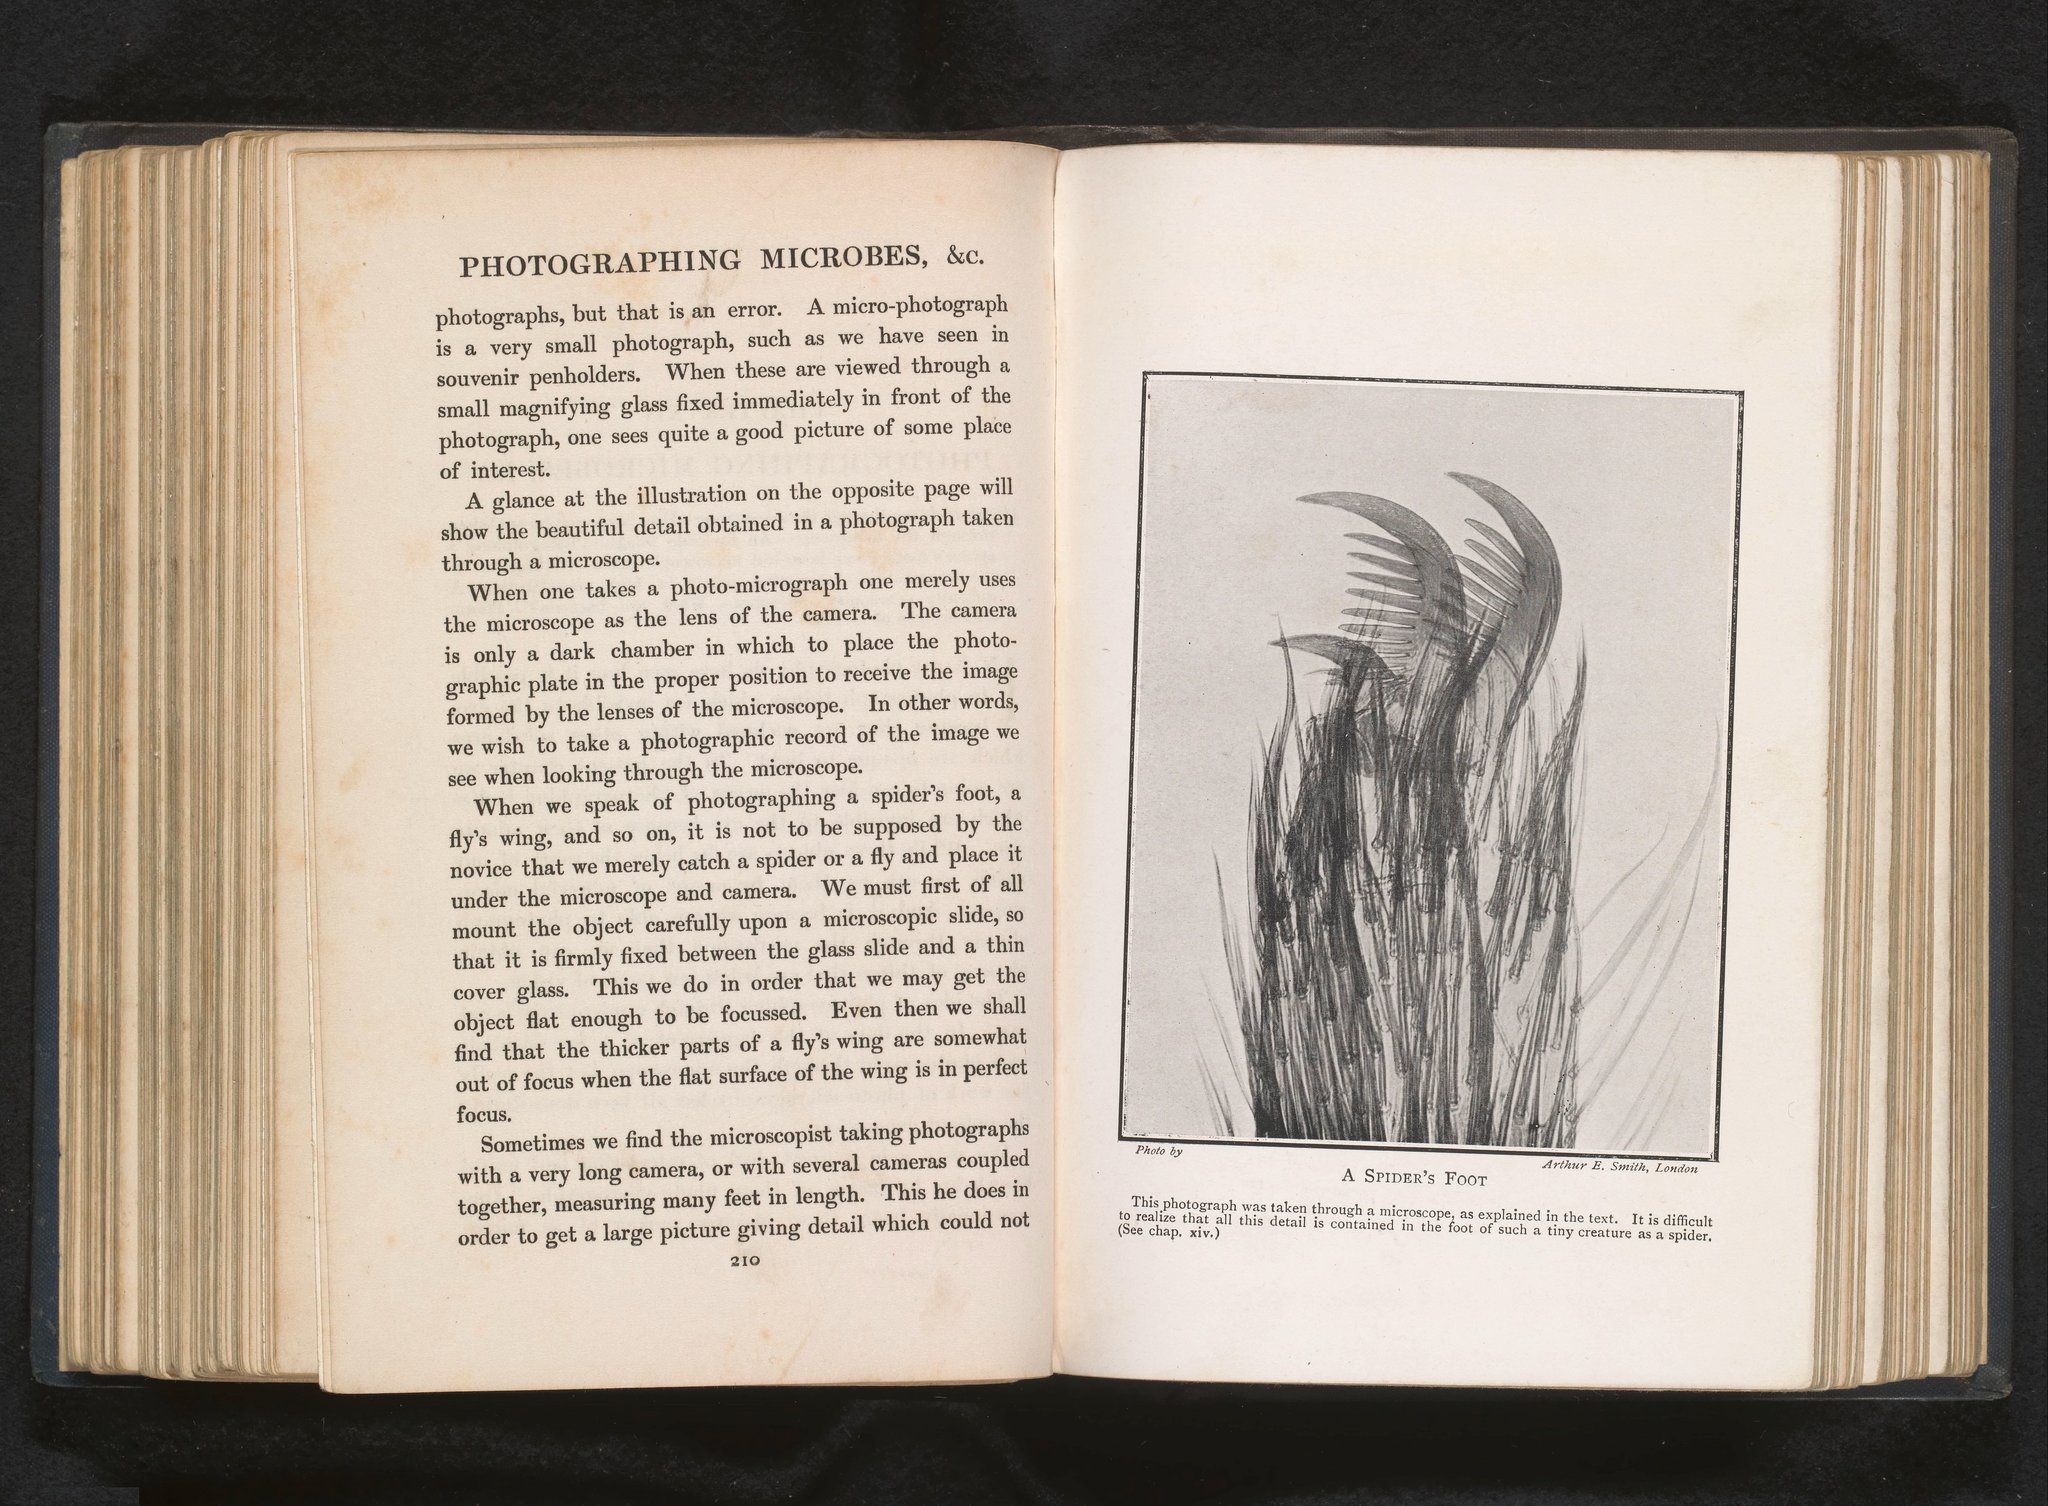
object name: photomechanical print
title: A spider's foot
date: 1898-1908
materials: paper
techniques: autotype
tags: spiders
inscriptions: inscription: ‘This photograph was taken through a microscope as explained in the text. It is difficult to realize that all this detail is contained in the foot of such a tiny creature as a spider. (See chap. xiv.)’